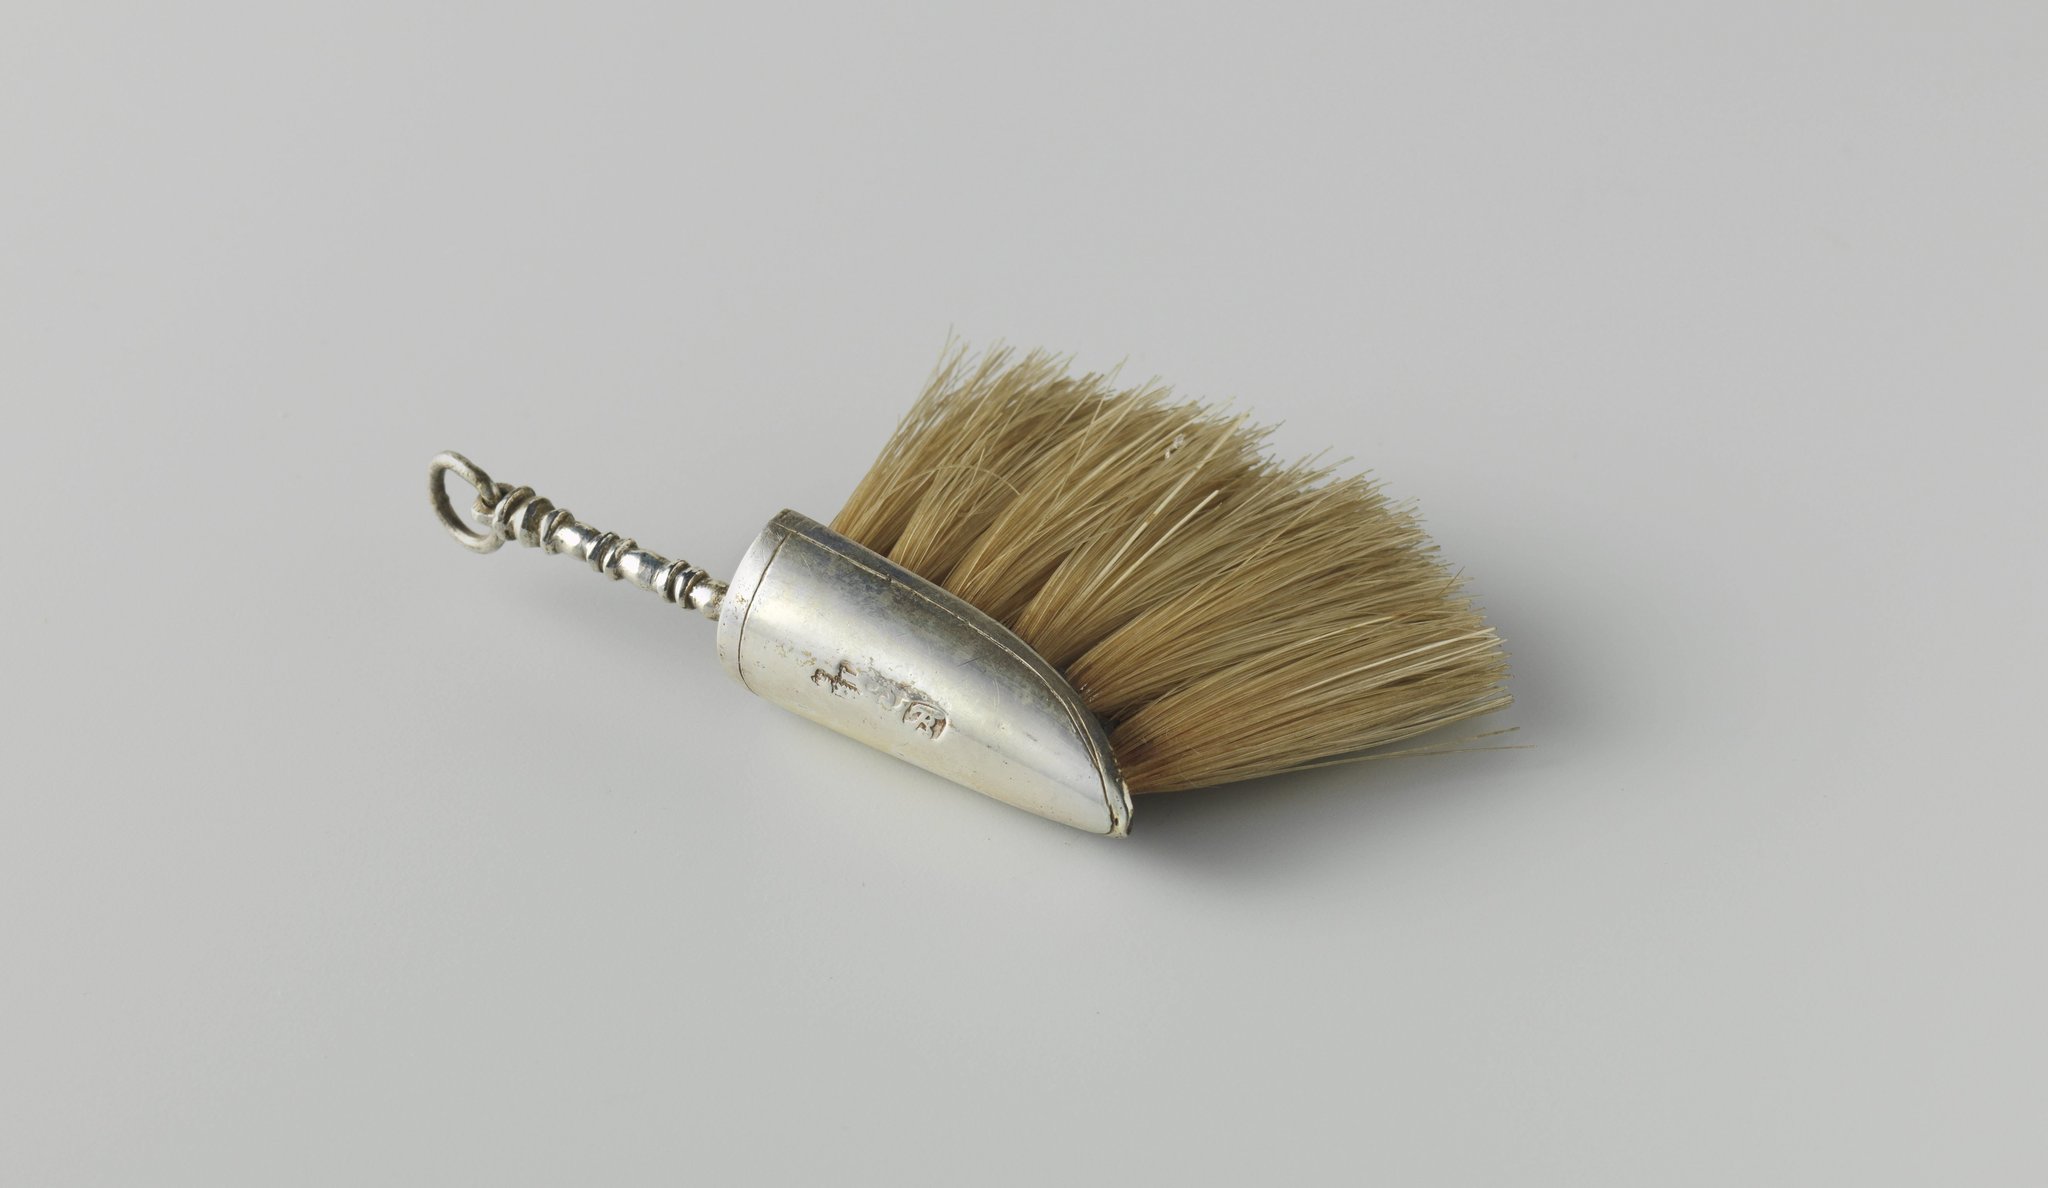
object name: miniature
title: Stoffer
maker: jan borduur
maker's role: silversmith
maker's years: 1698-1766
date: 1743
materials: silver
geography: amsterdam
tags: (household) utensils and implements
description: Stoffer met ronde rug, lange haren en een geprofileerd handvat met aan het eind een ring. De stoffer is gemerkt: stk.= Amsterdam, jrl.= I (1743), mt.= Jan Borduur.